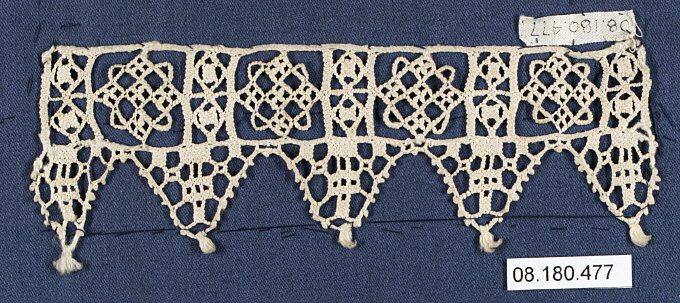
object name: border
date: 1601-1700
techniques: lace